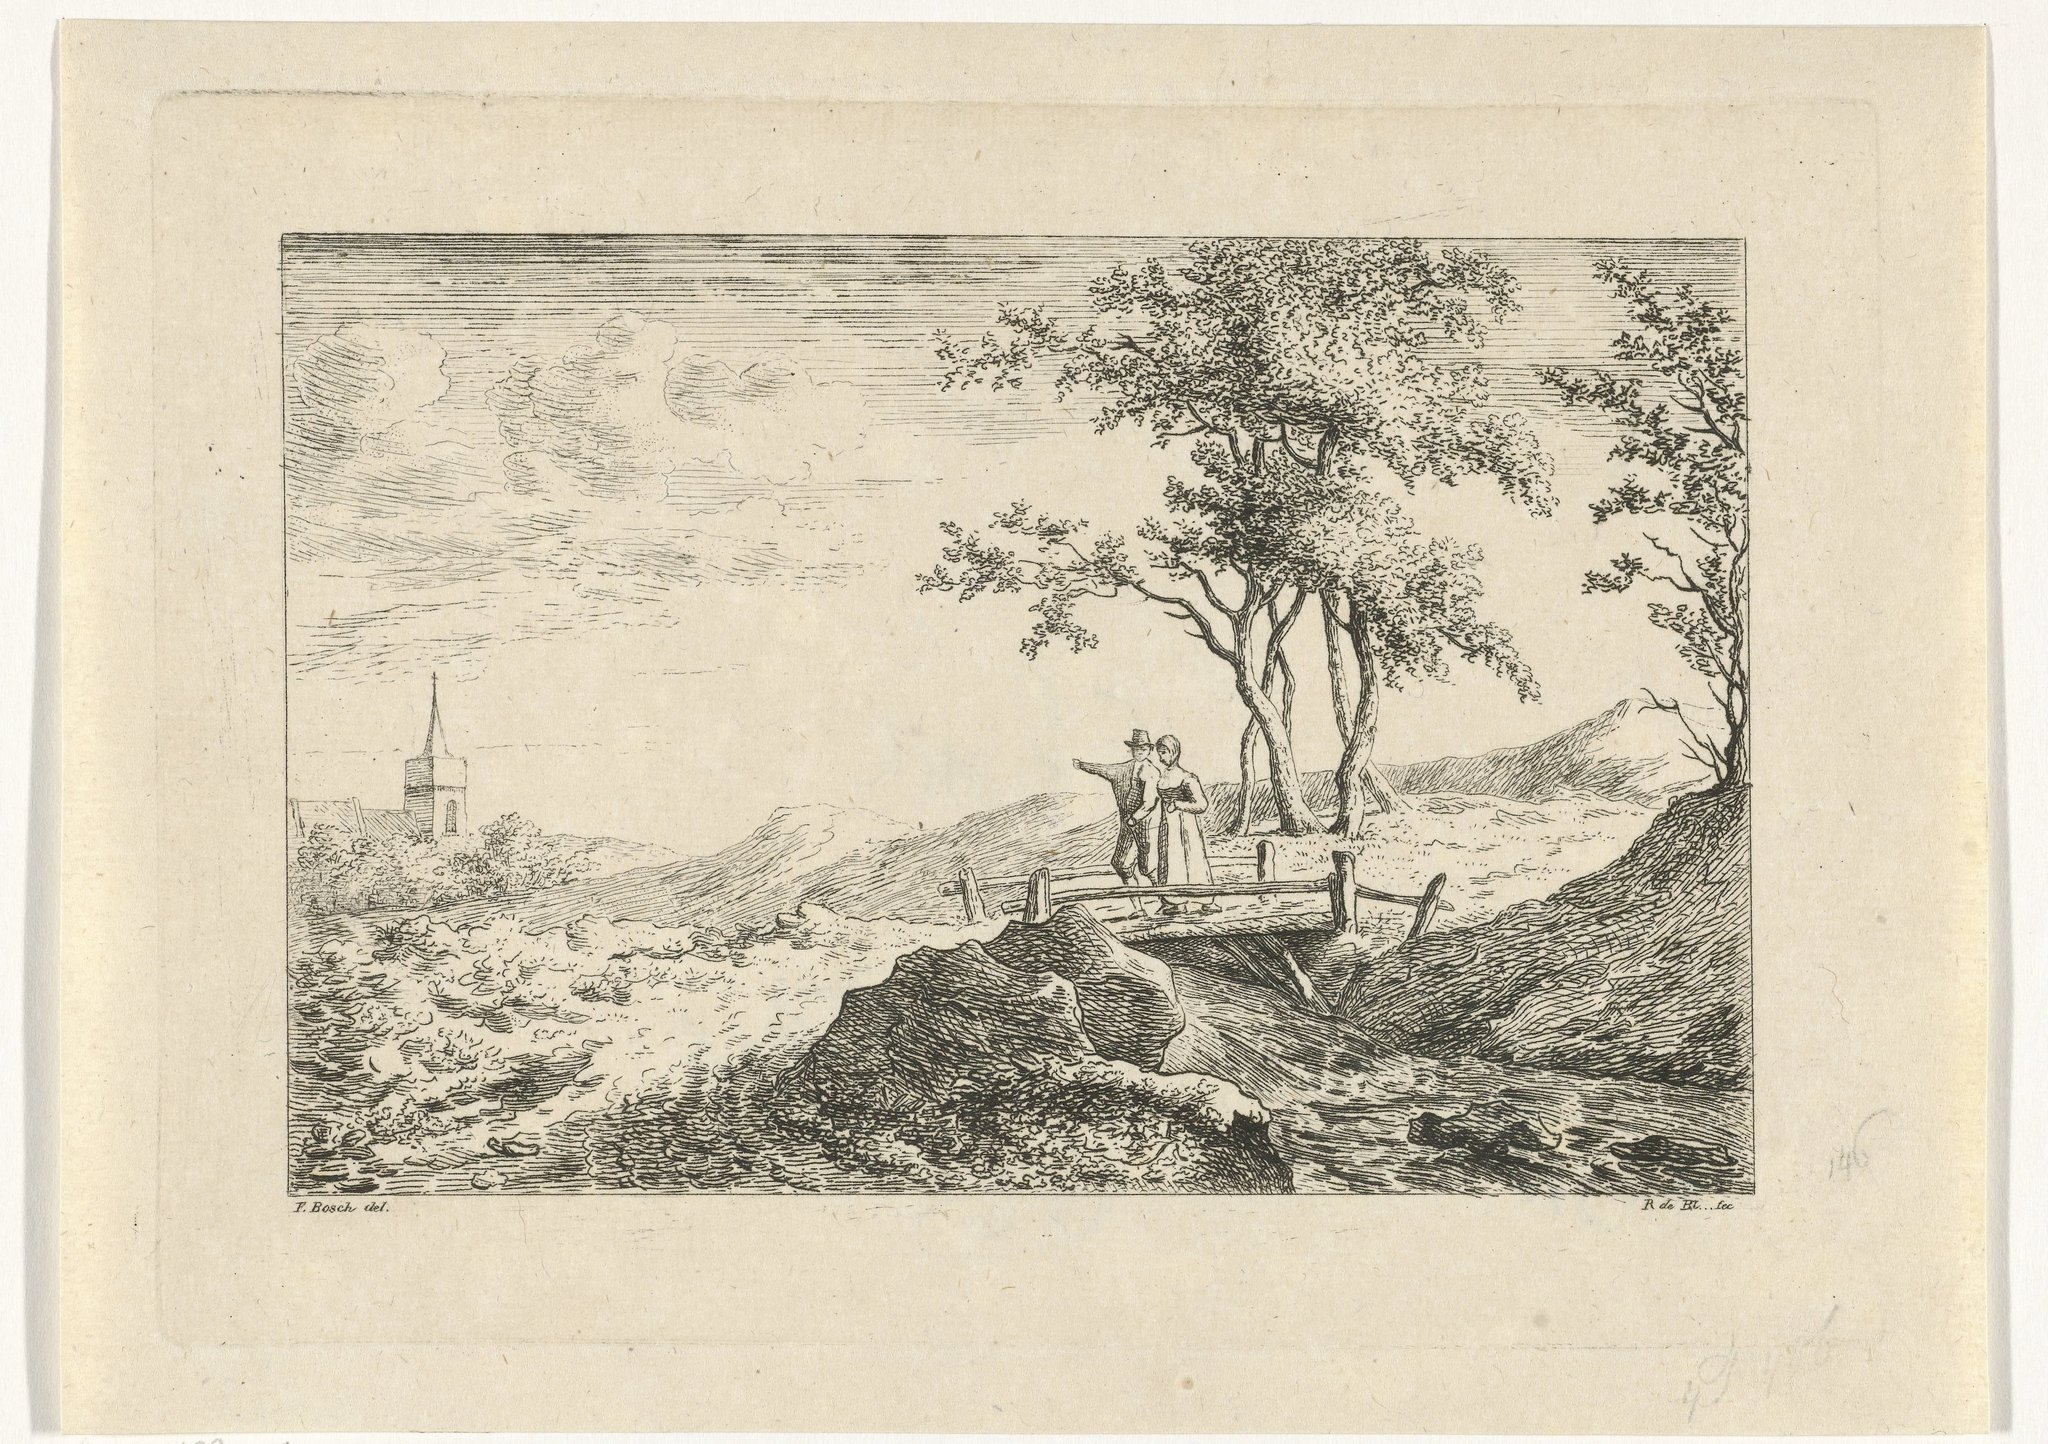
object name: print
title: Paar op een houten brug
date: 1796-1856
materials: paper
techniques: engraving, etching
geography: vaassen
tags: landscape with bridge, viaduct or aqueduct, index finger forwards, pointing, indicating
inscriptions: collector's mark: Lugt 2228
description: Een man en vrouw lopen naast elkaar op een houten brug. De man wijst naar de kerktoren links.